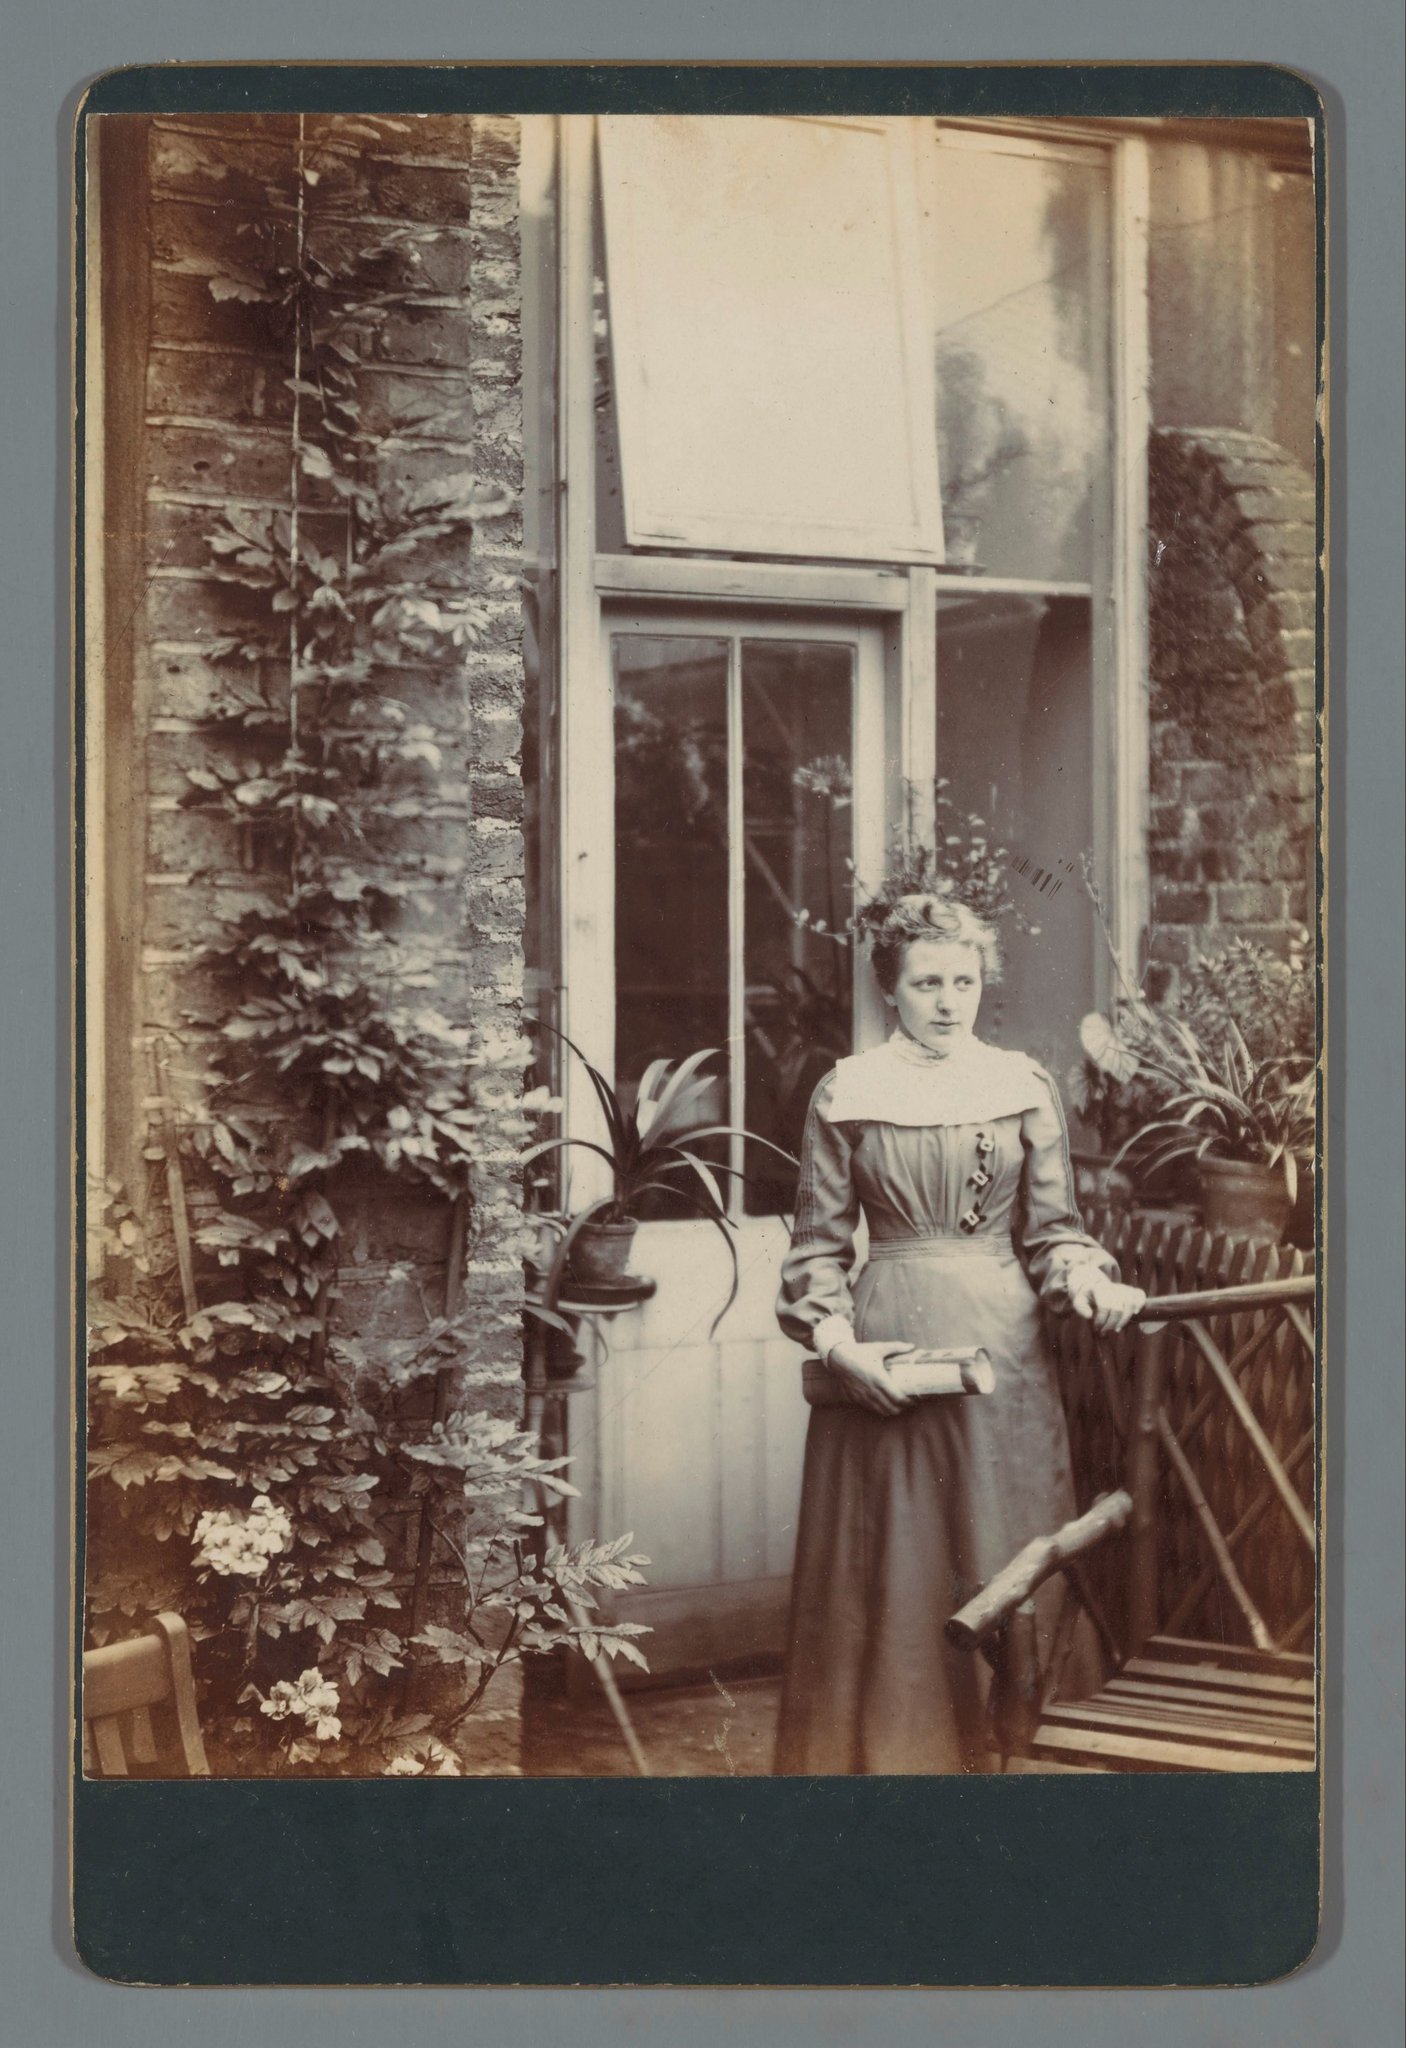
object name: photograph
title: Portret van een jonge vrouw in tuin bij achterdeur van een huis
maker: Anonymous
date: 1910-1920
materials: cardboard, photographic support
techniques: gelatin silver print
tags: neck-gear ~ clothing, closed door